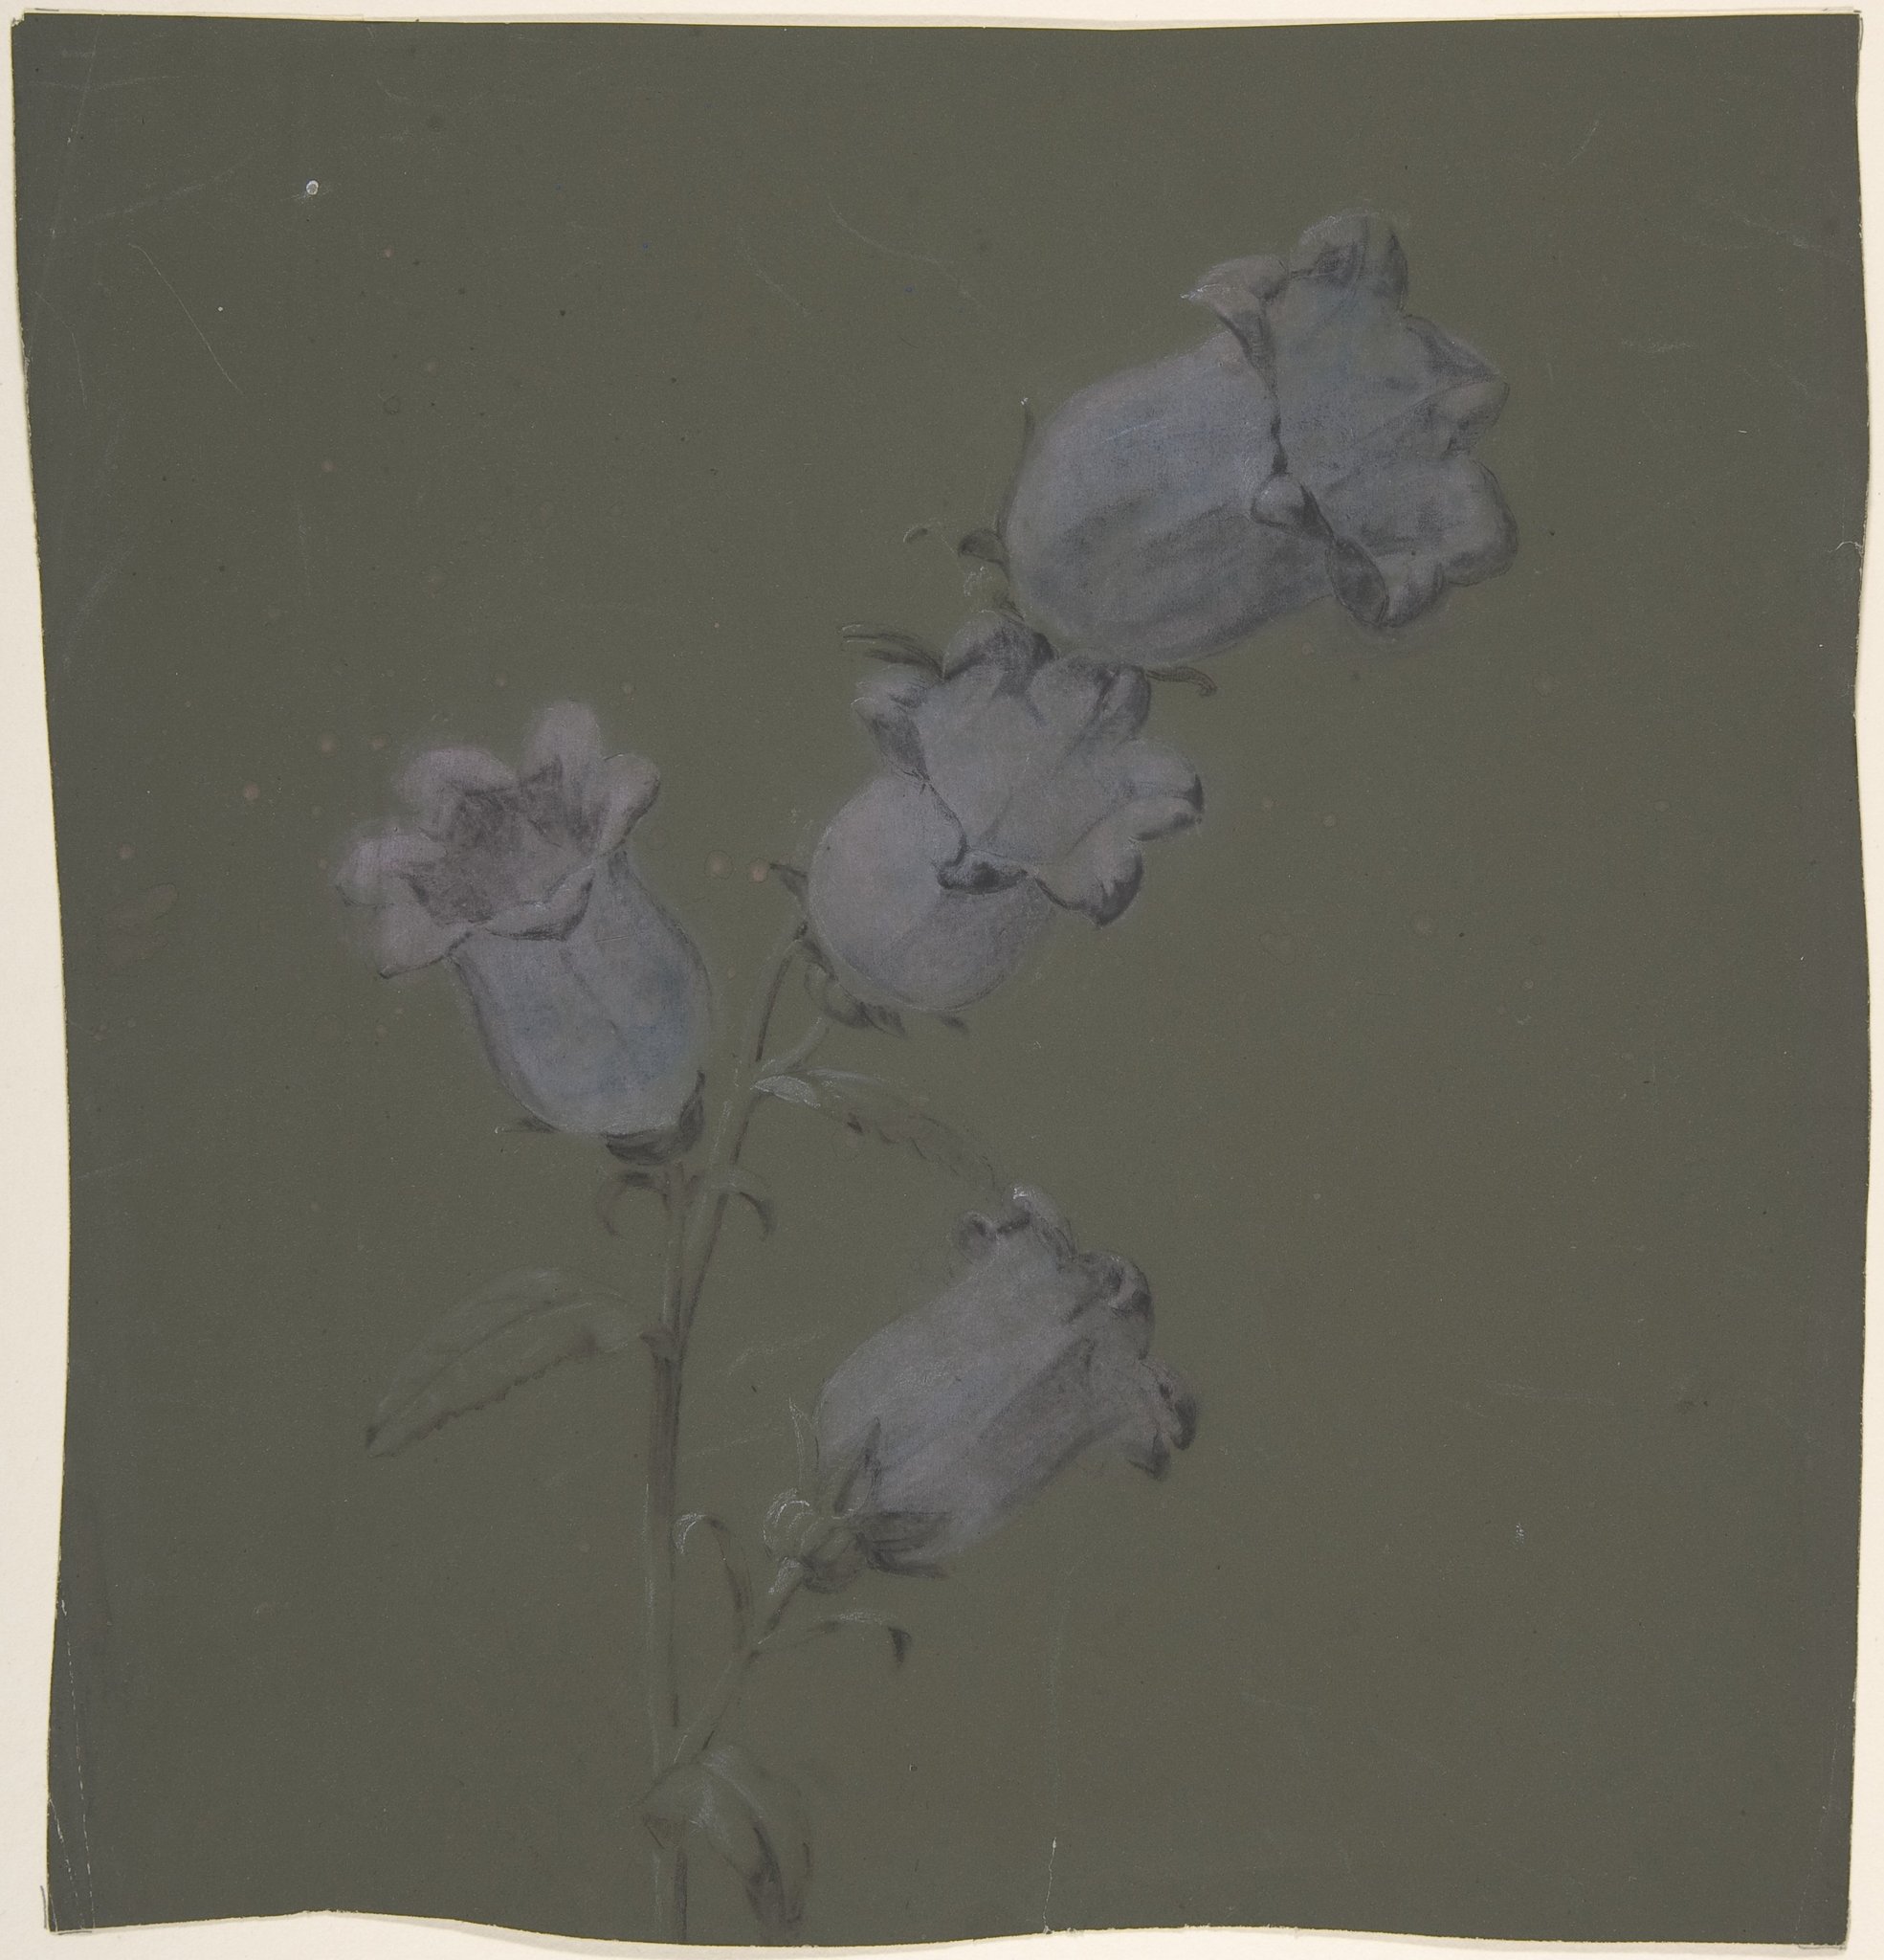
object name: drawing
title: Spray of Canterbury Bells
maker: antoine berjon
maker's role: artist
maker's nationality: french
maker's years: 1754-1843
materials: chalk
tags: flowers